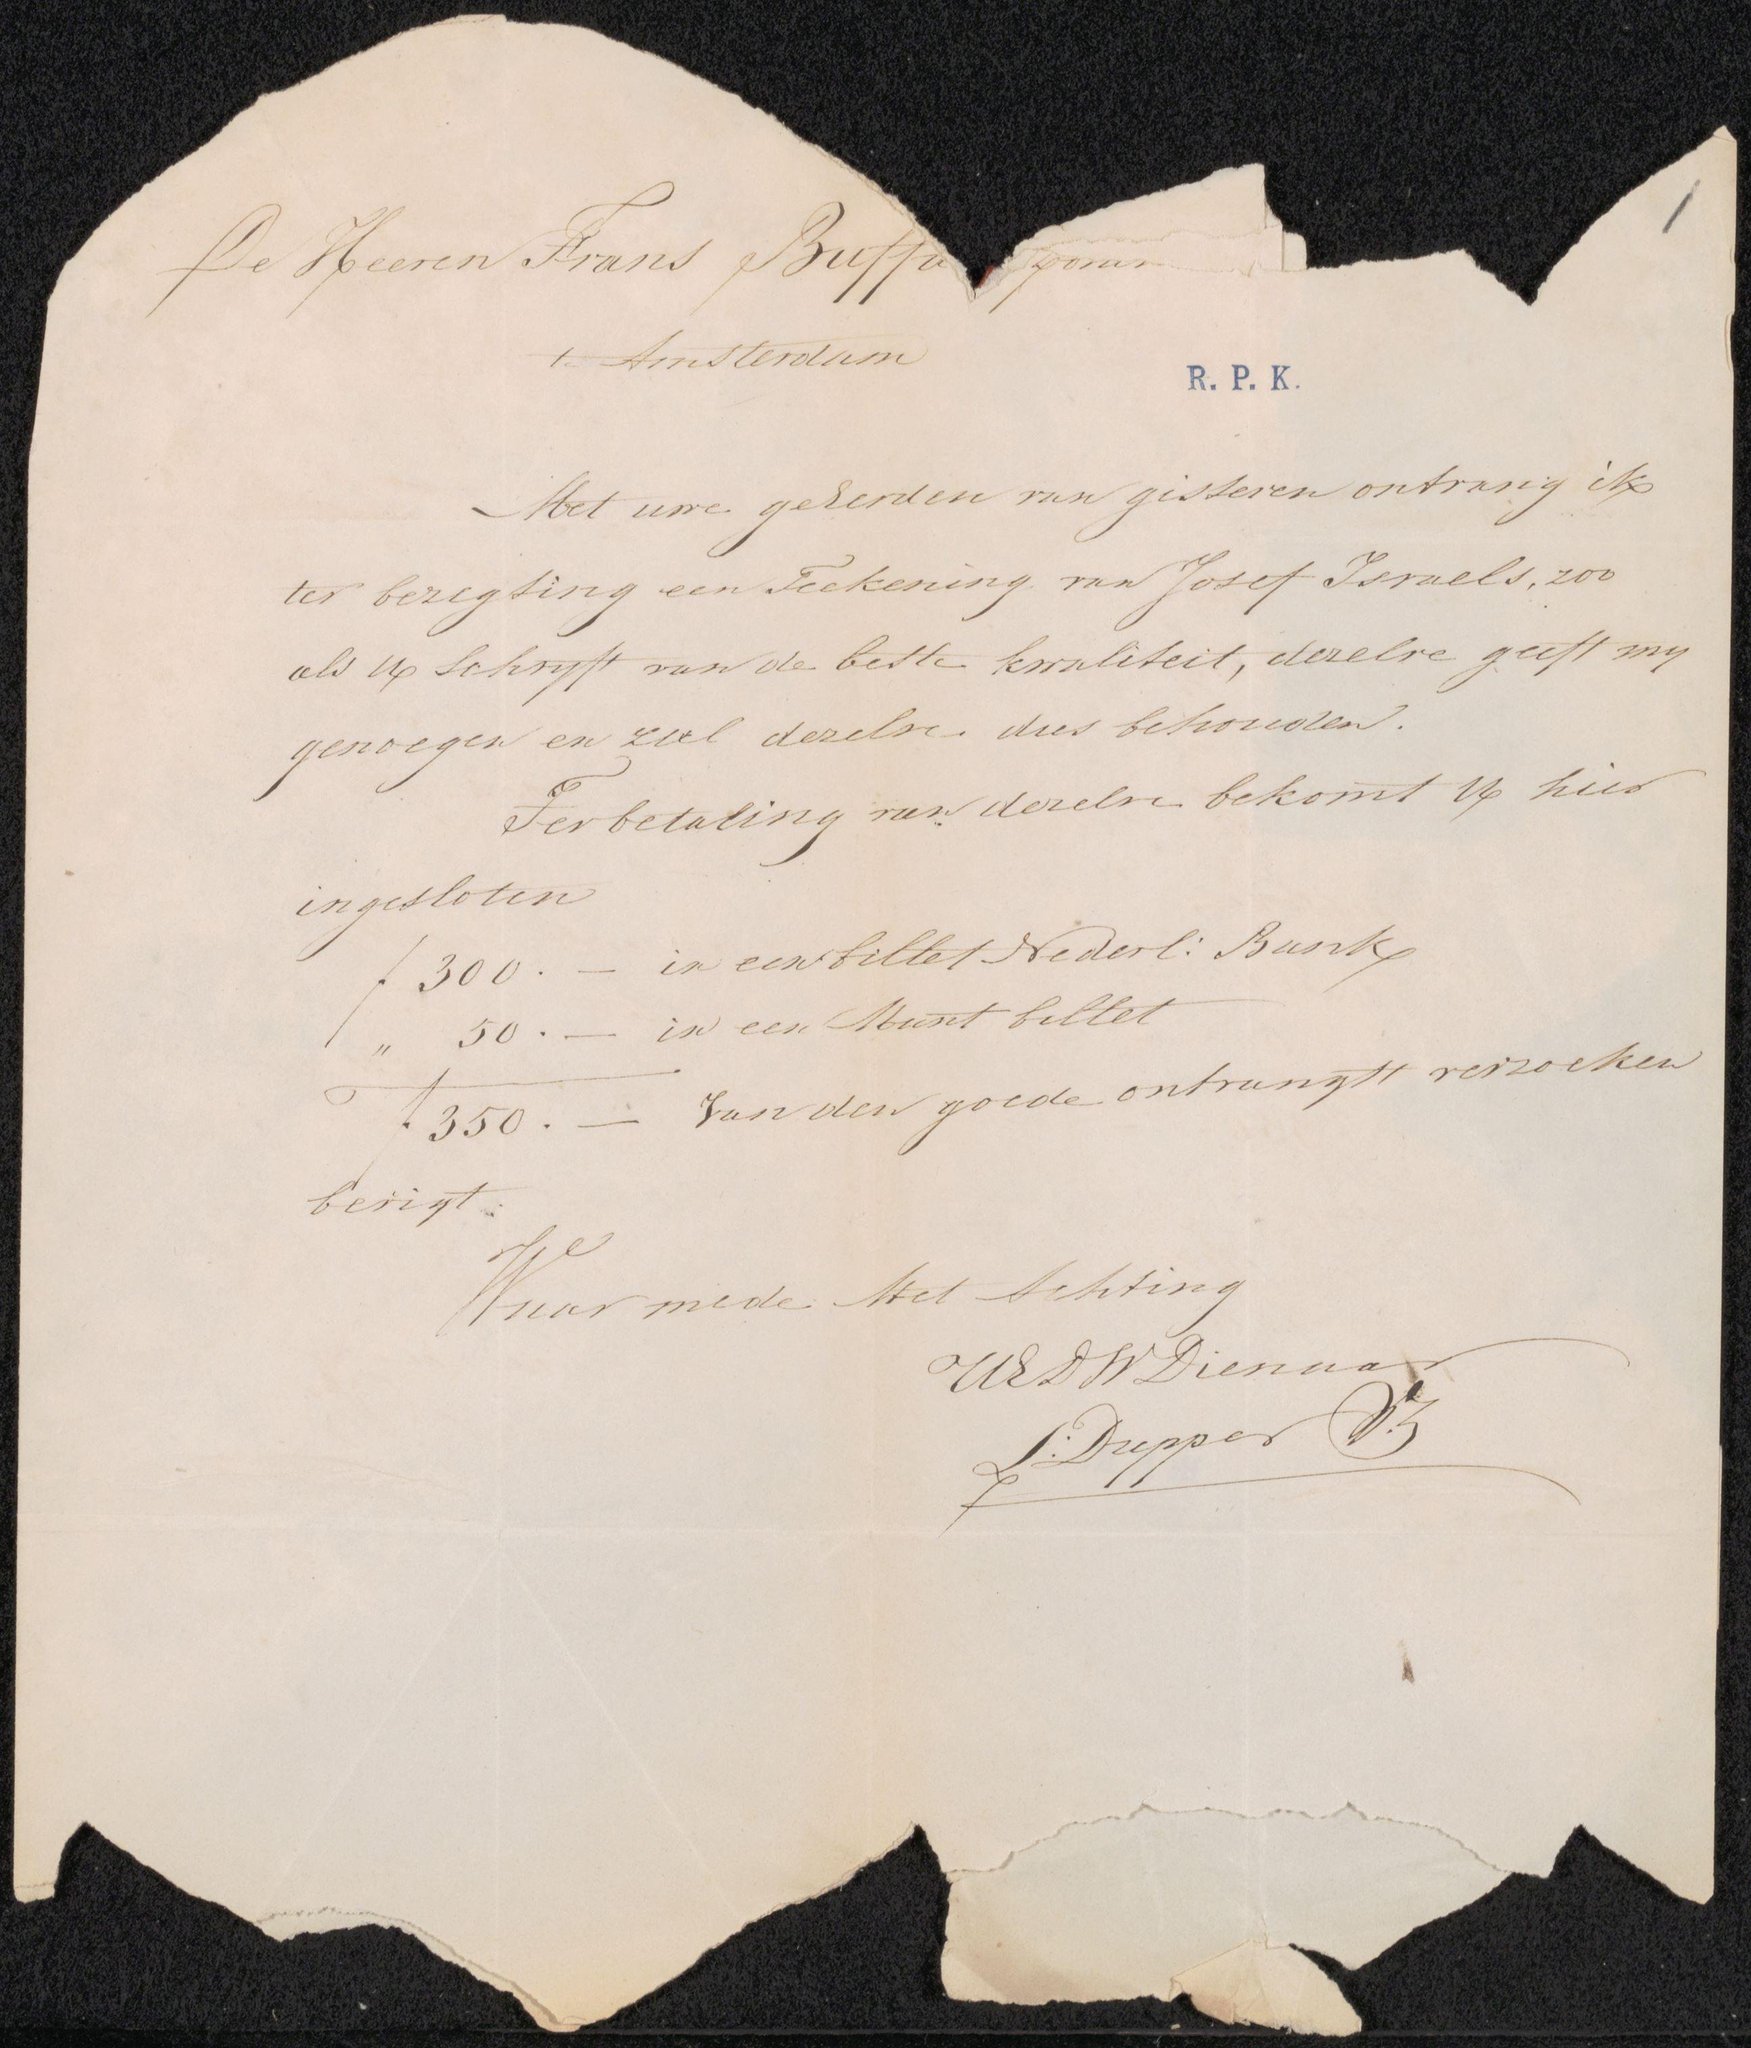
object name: letter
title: Brief aan Frans Buffa en Zonen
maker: leendert dupper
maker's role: amateurtekenaar, aquarellist, kunstverzamelaar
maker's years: 1799-1870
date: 1860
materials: ink, paper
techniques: pen, writing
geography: dordrecht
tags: amsterdam, painter, draughtsman, hendrik jacobus scholten, david bles, paris, alexandre-gabriel decamps, publisher, henri j. zimmerman, art trade, art shop, drawing, art collecting, money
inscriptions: collector's mark: Lugt 2233, seal